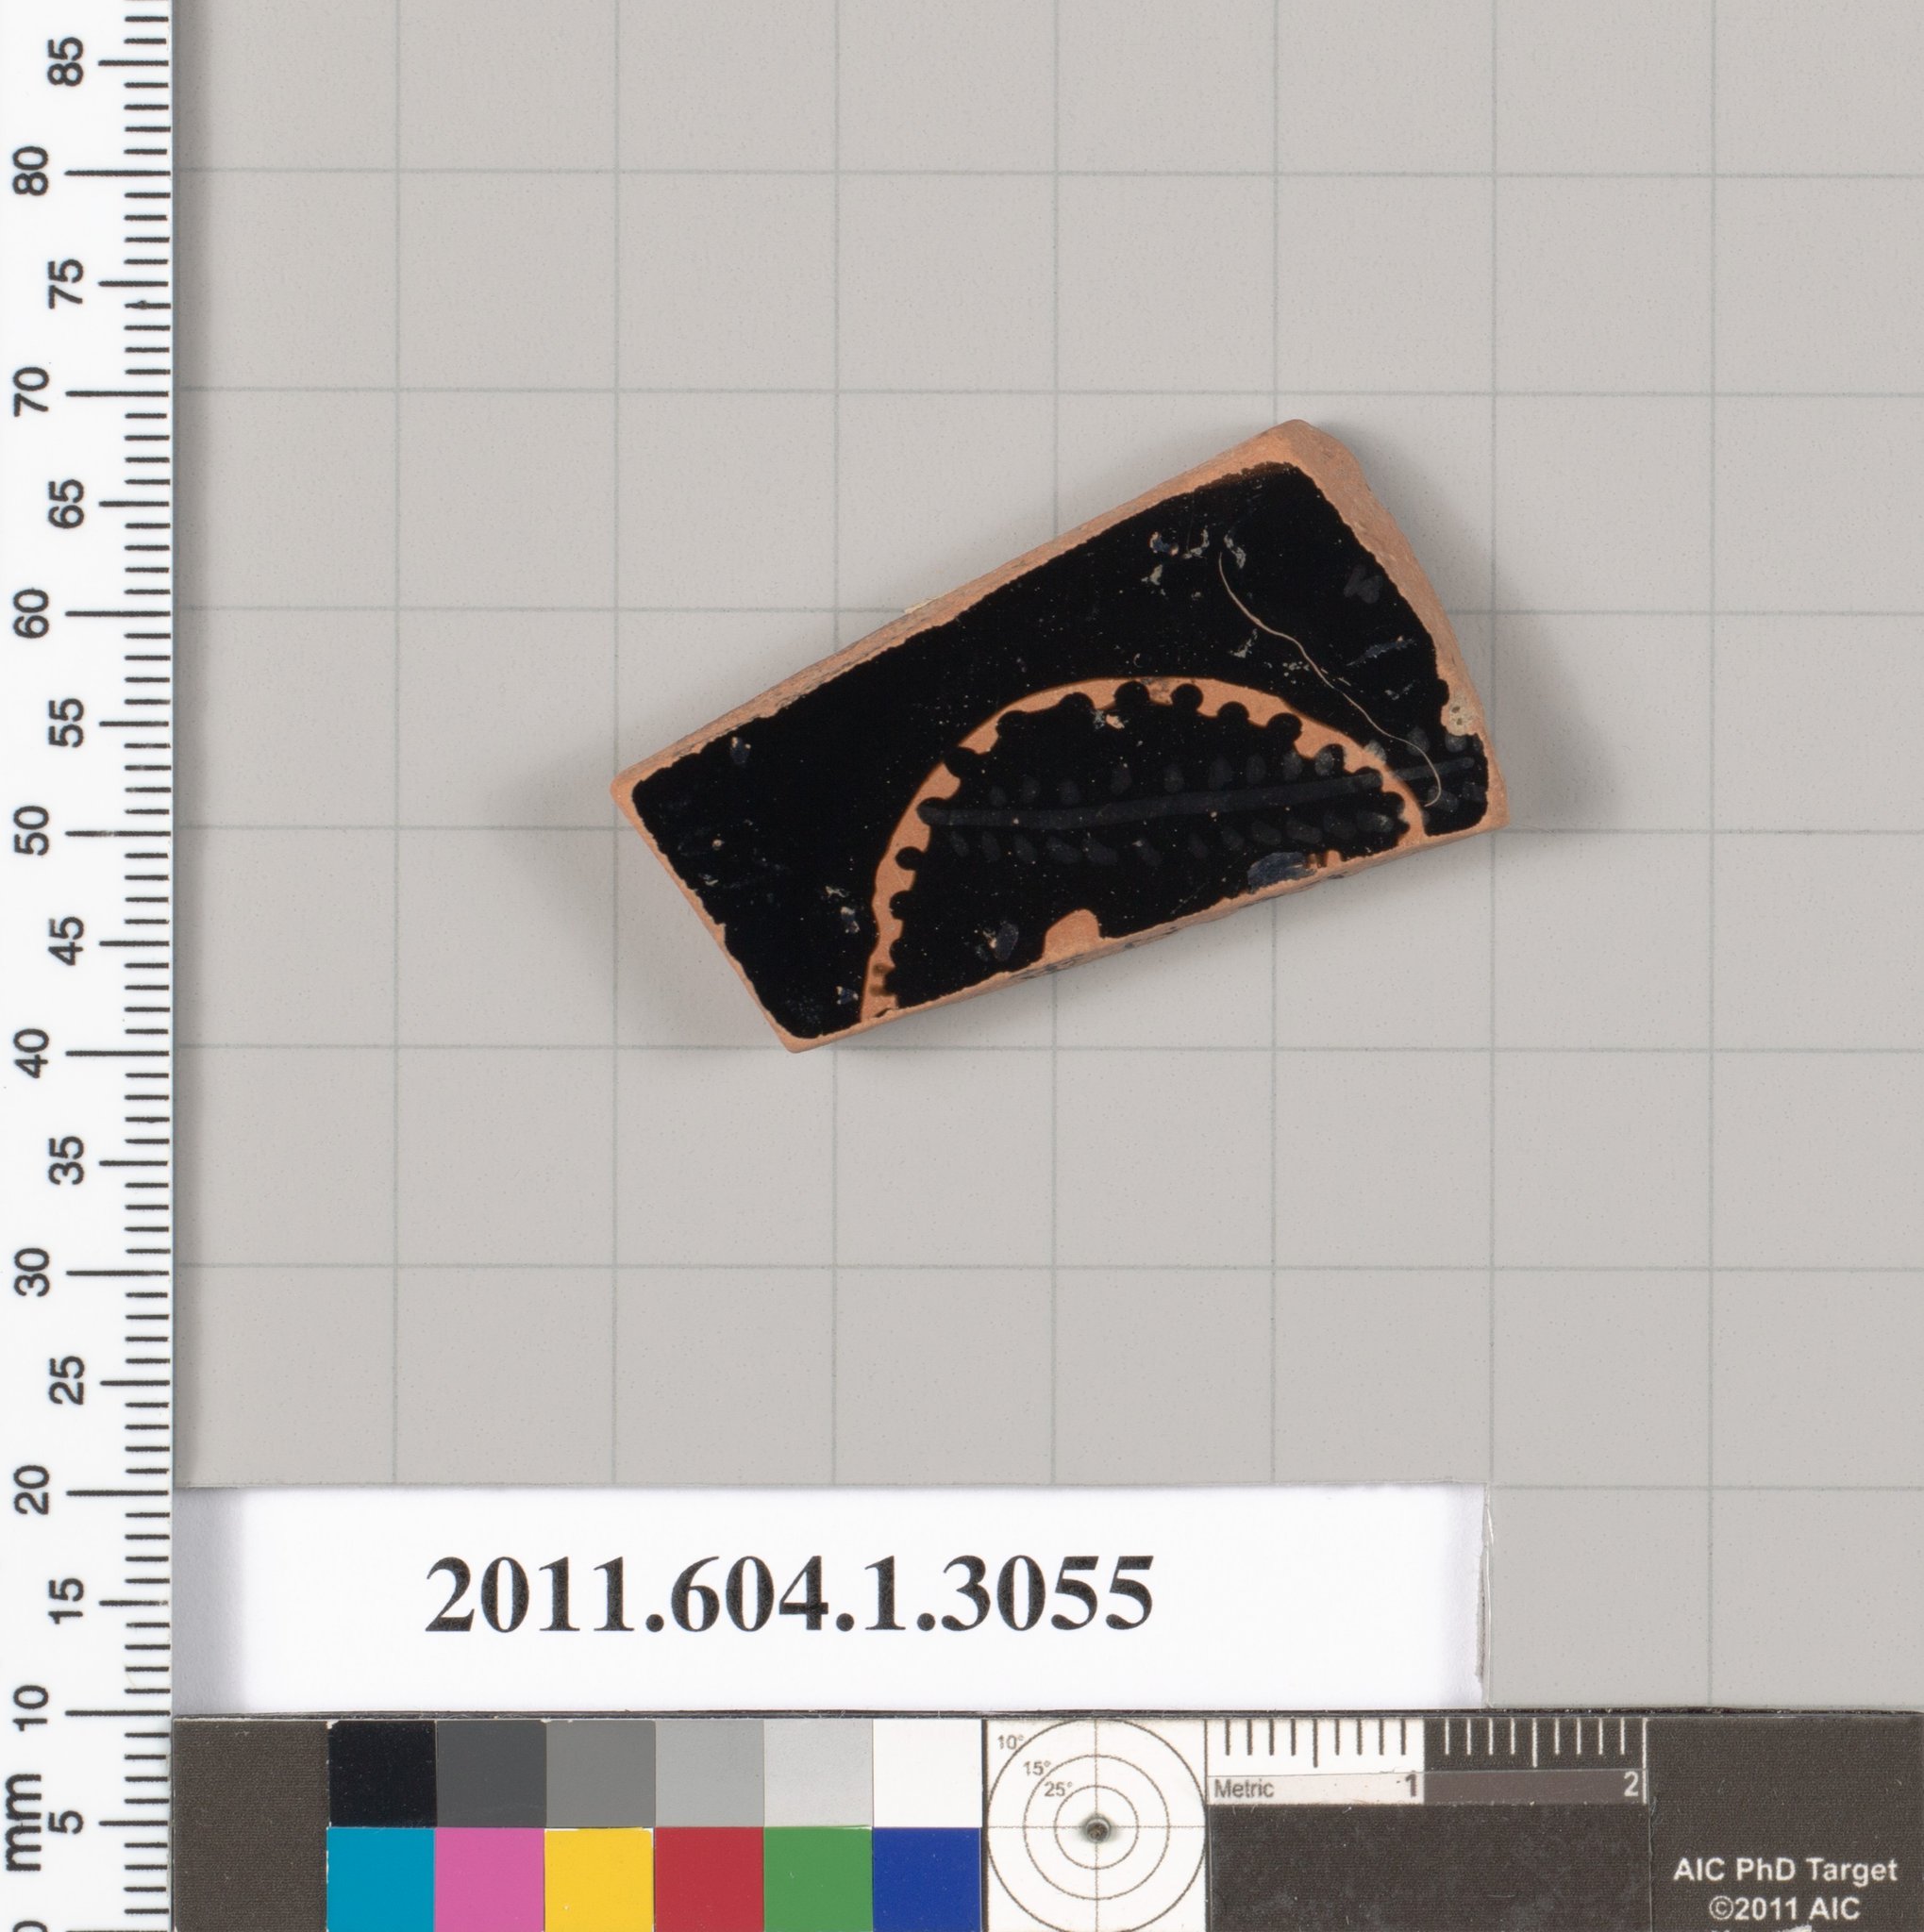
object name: kylix fragment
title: Terracotta fragment of a kylix (drinking cup)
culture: greek, attic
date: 520-500 BCE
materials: terracotta